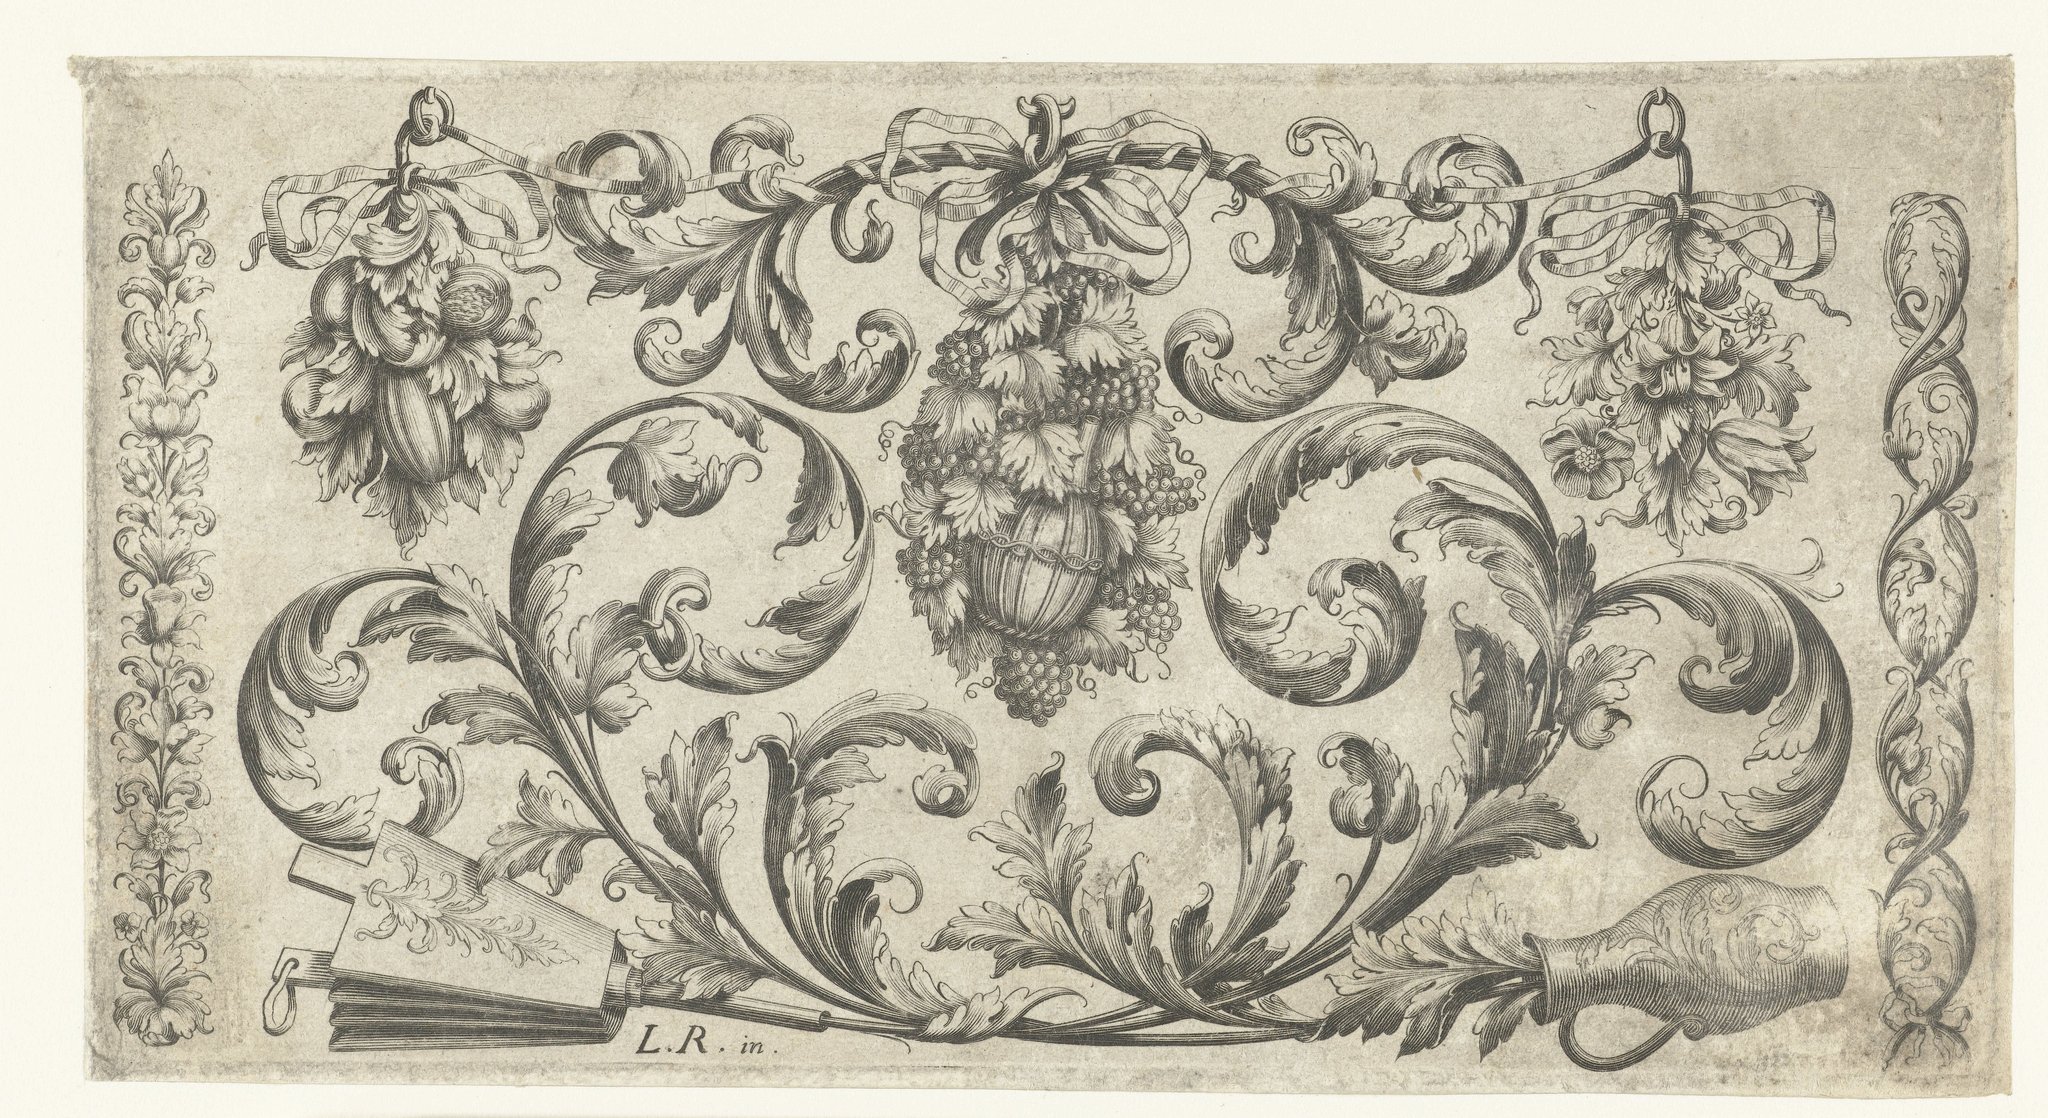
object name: print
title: Ornamenten voor edelsmeden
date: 1668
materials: paper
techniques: engraving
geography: paris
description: Linksonder ligt een blaasbalg. Uit serie van 7 bladen, eerste editie.